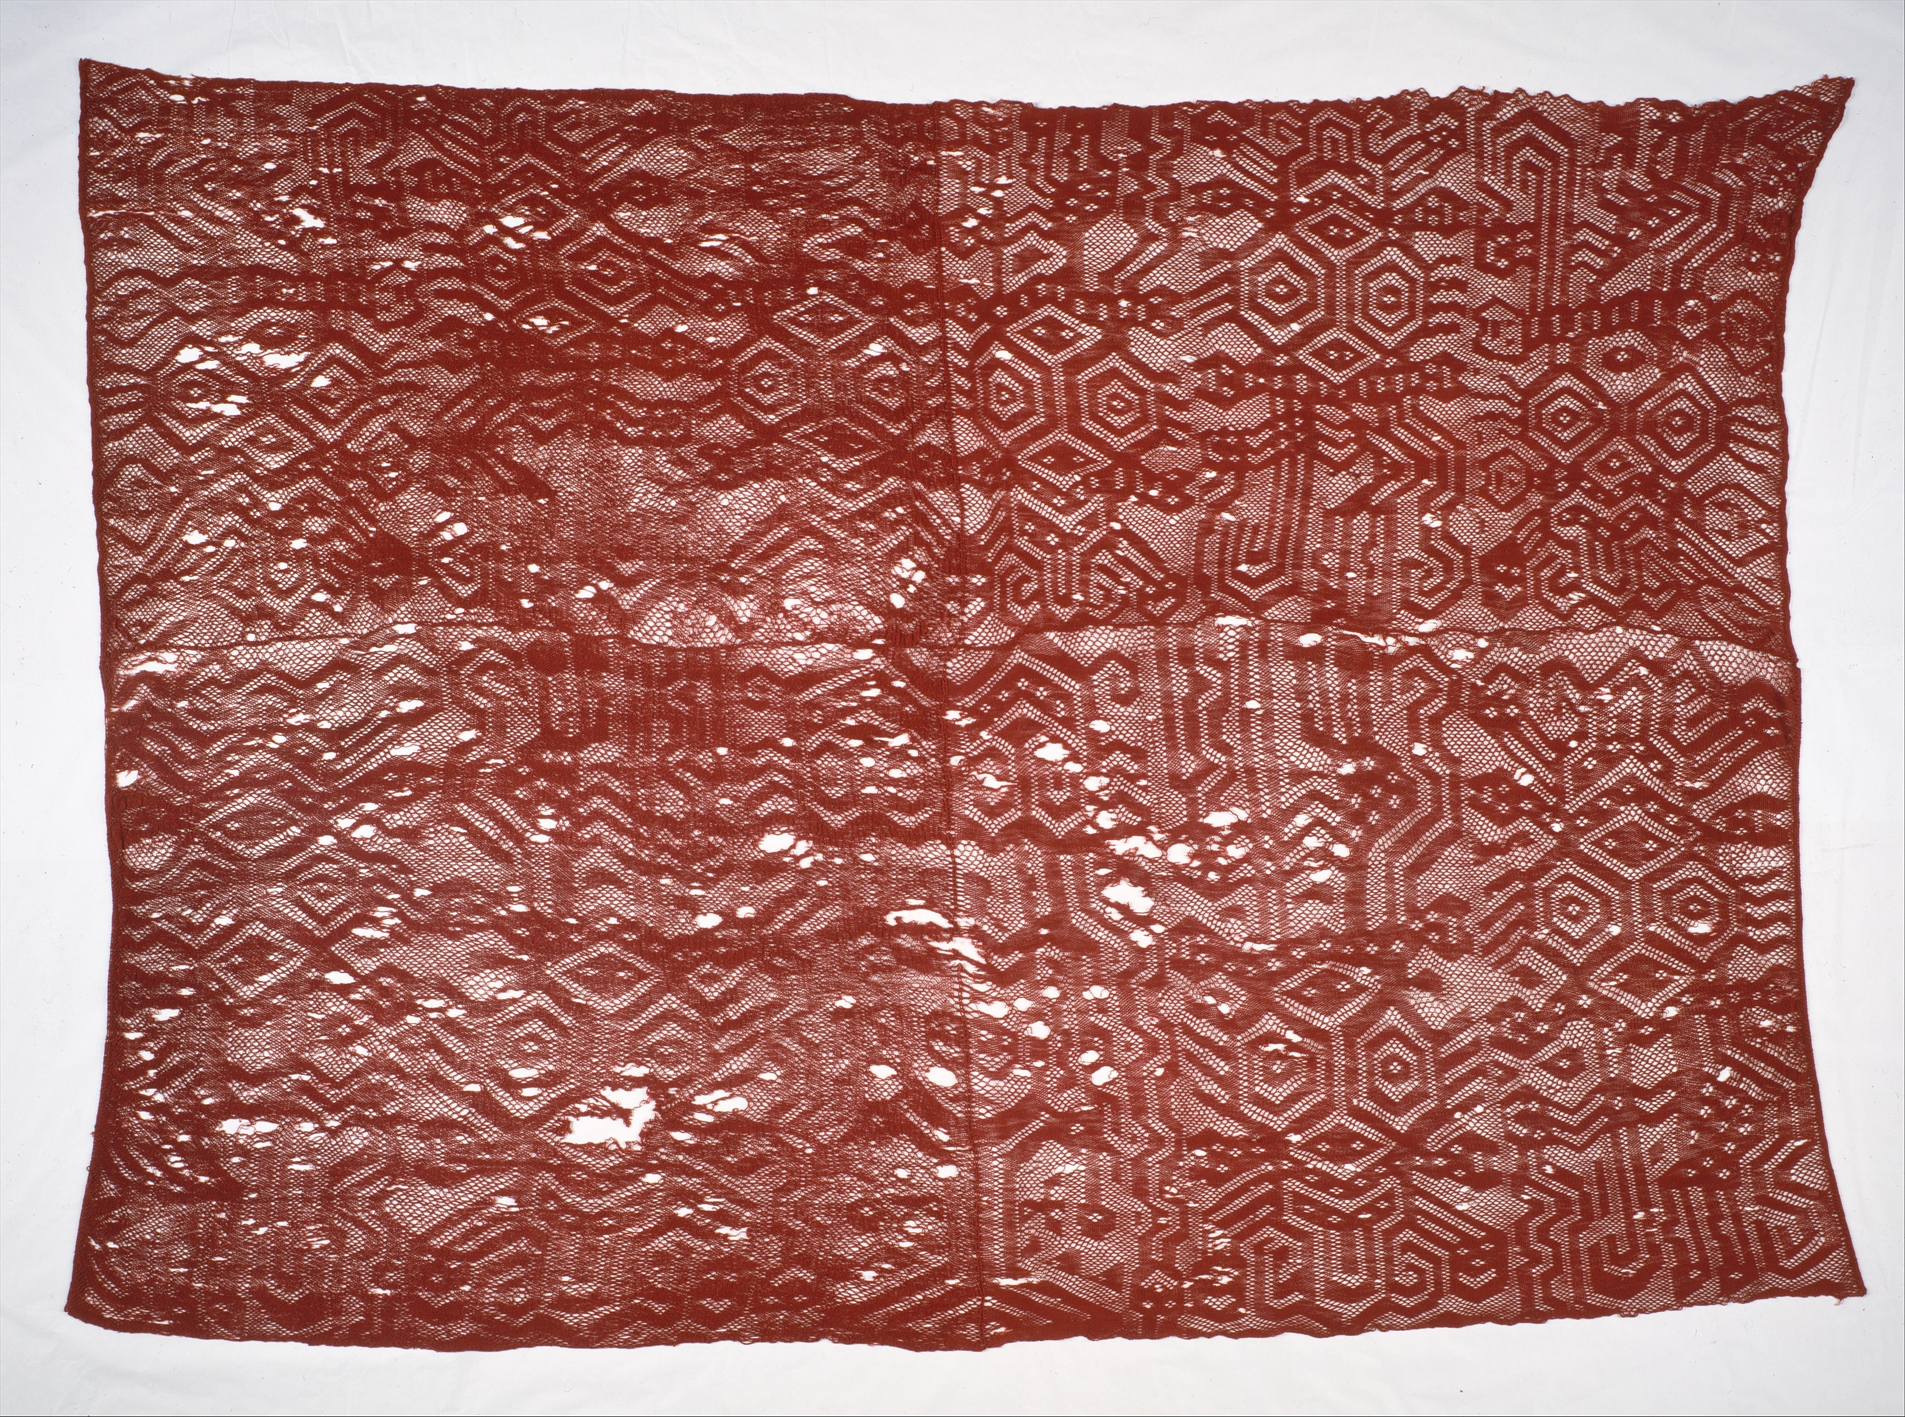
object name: mantle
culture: ocucaje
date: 200-1 BCE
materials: animal fiber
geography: peru